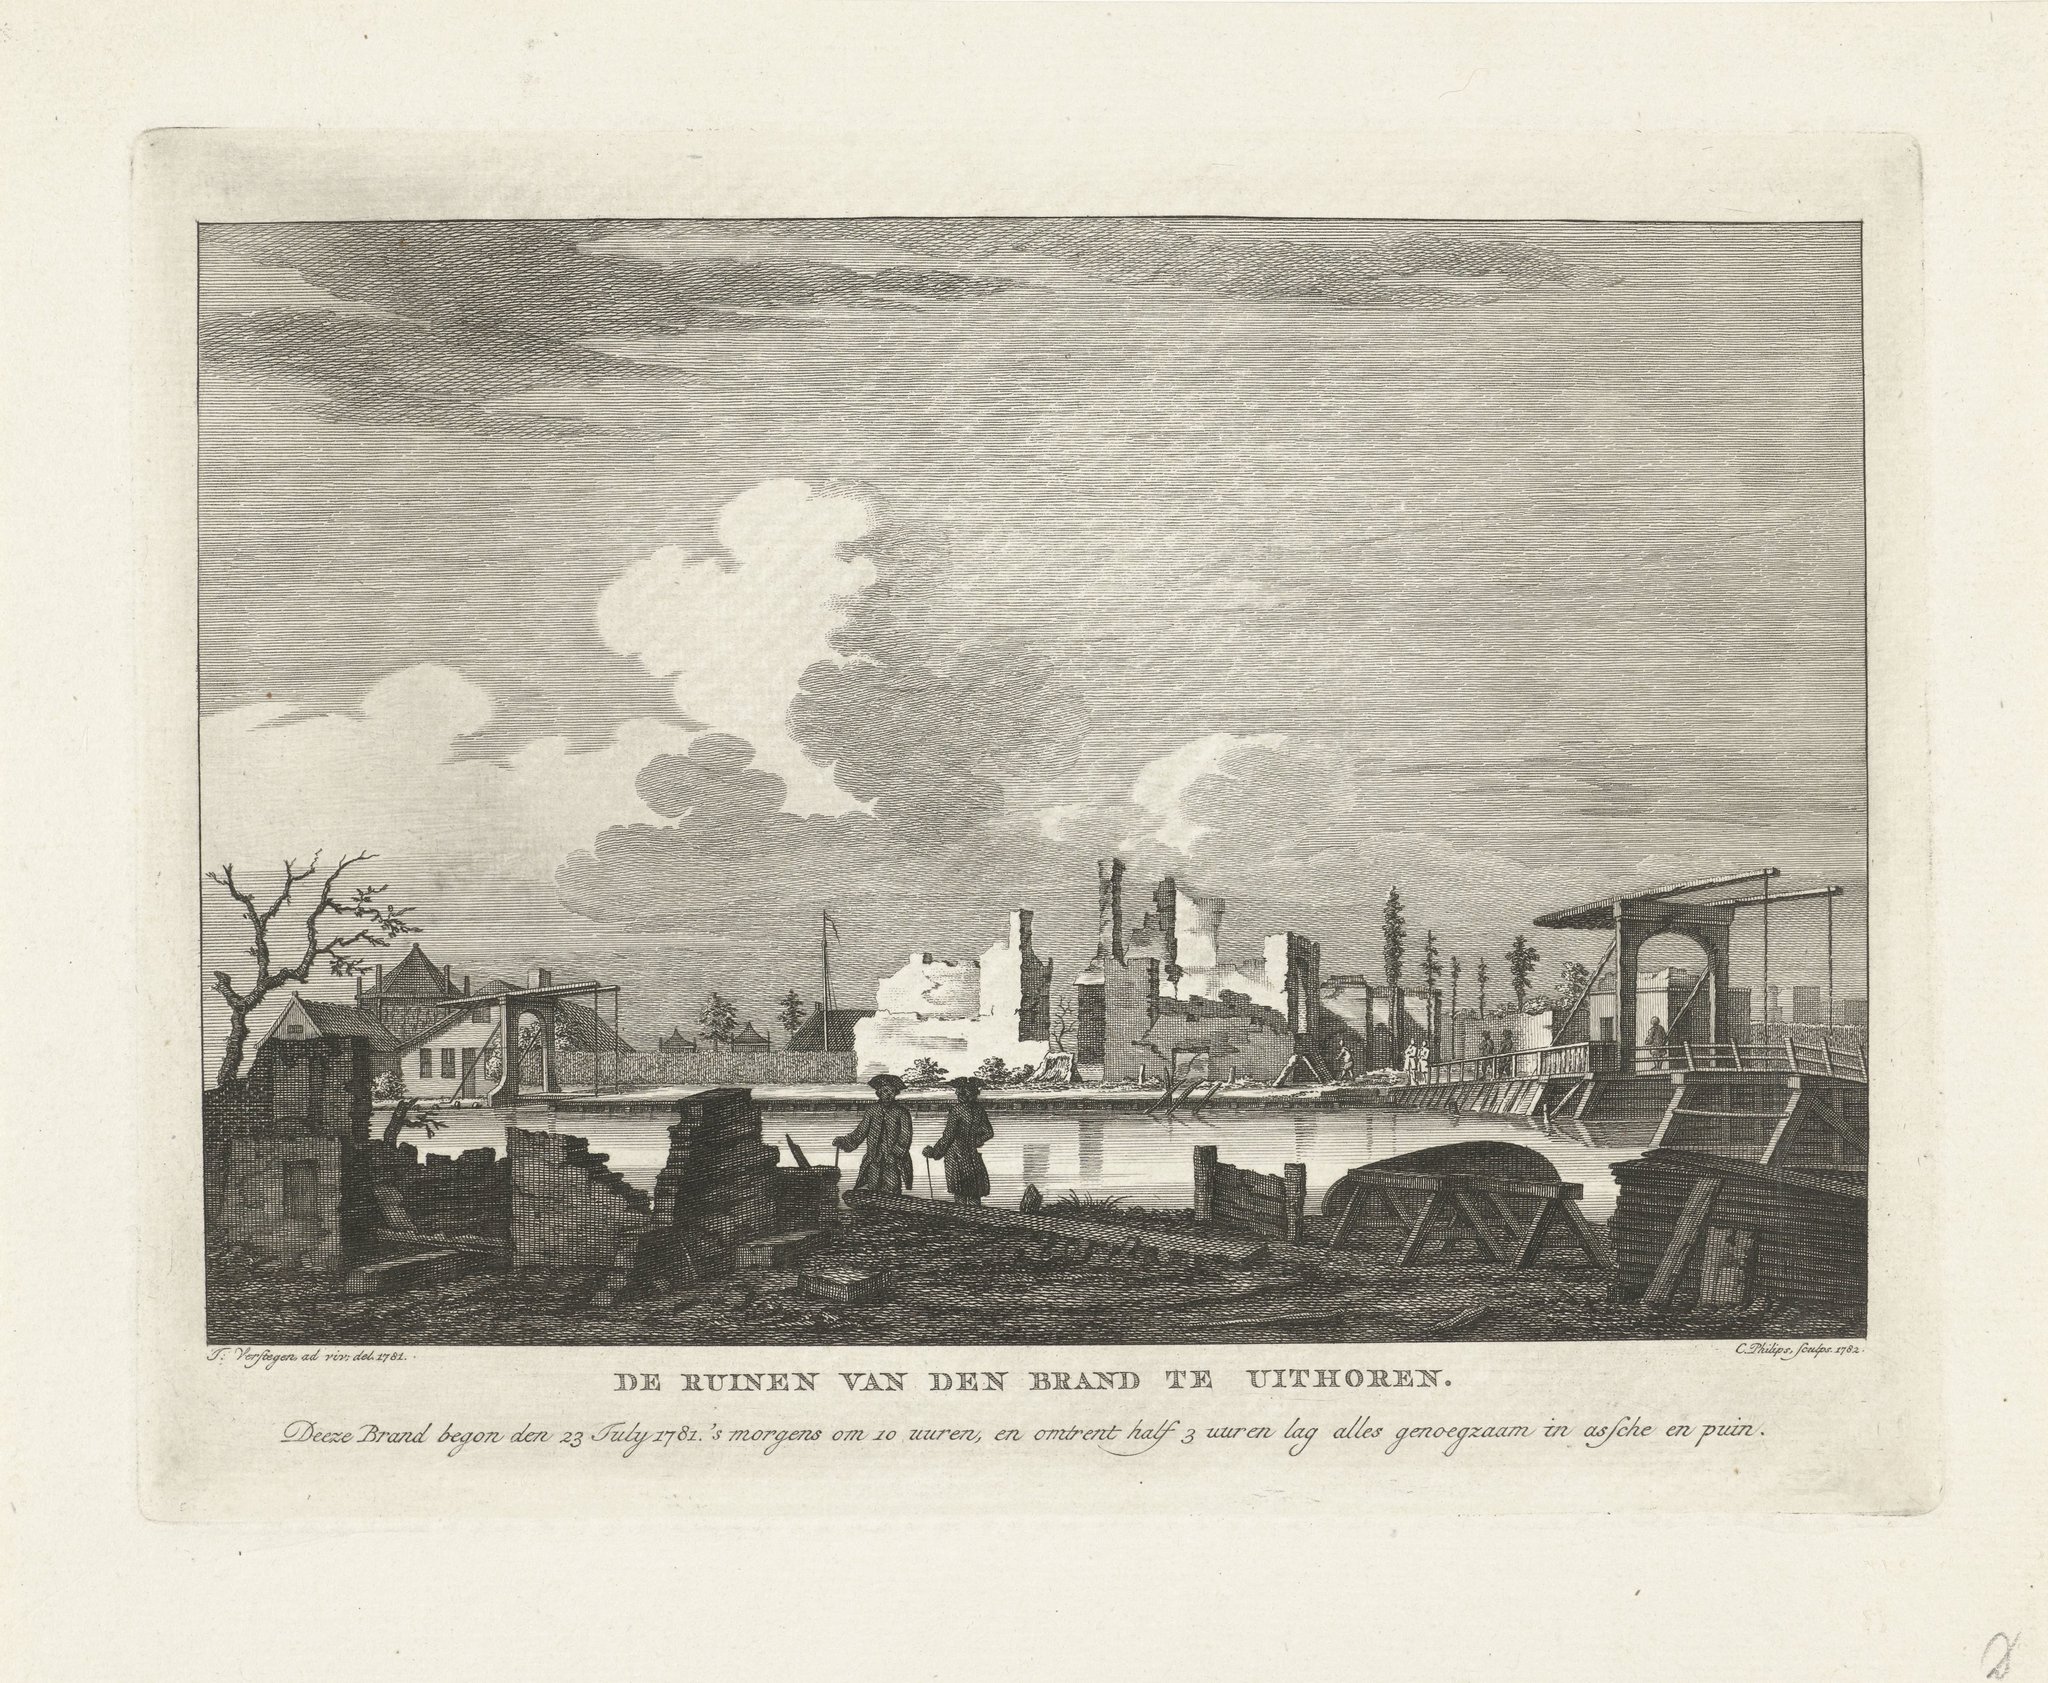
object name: print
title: Ruïnes na de brand te Uithoorn, 1781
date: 1782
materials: paper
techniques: engraving, etching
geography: uithoorn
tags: ruin of a dwelling, house, castle, etc.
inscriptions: collector's mark: Lugt 2228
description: Gezicht op de ruïnes na de brand in het dorp Uithoorn op 23 juli 1781. Onder de titel een eenregelig onderschrift.